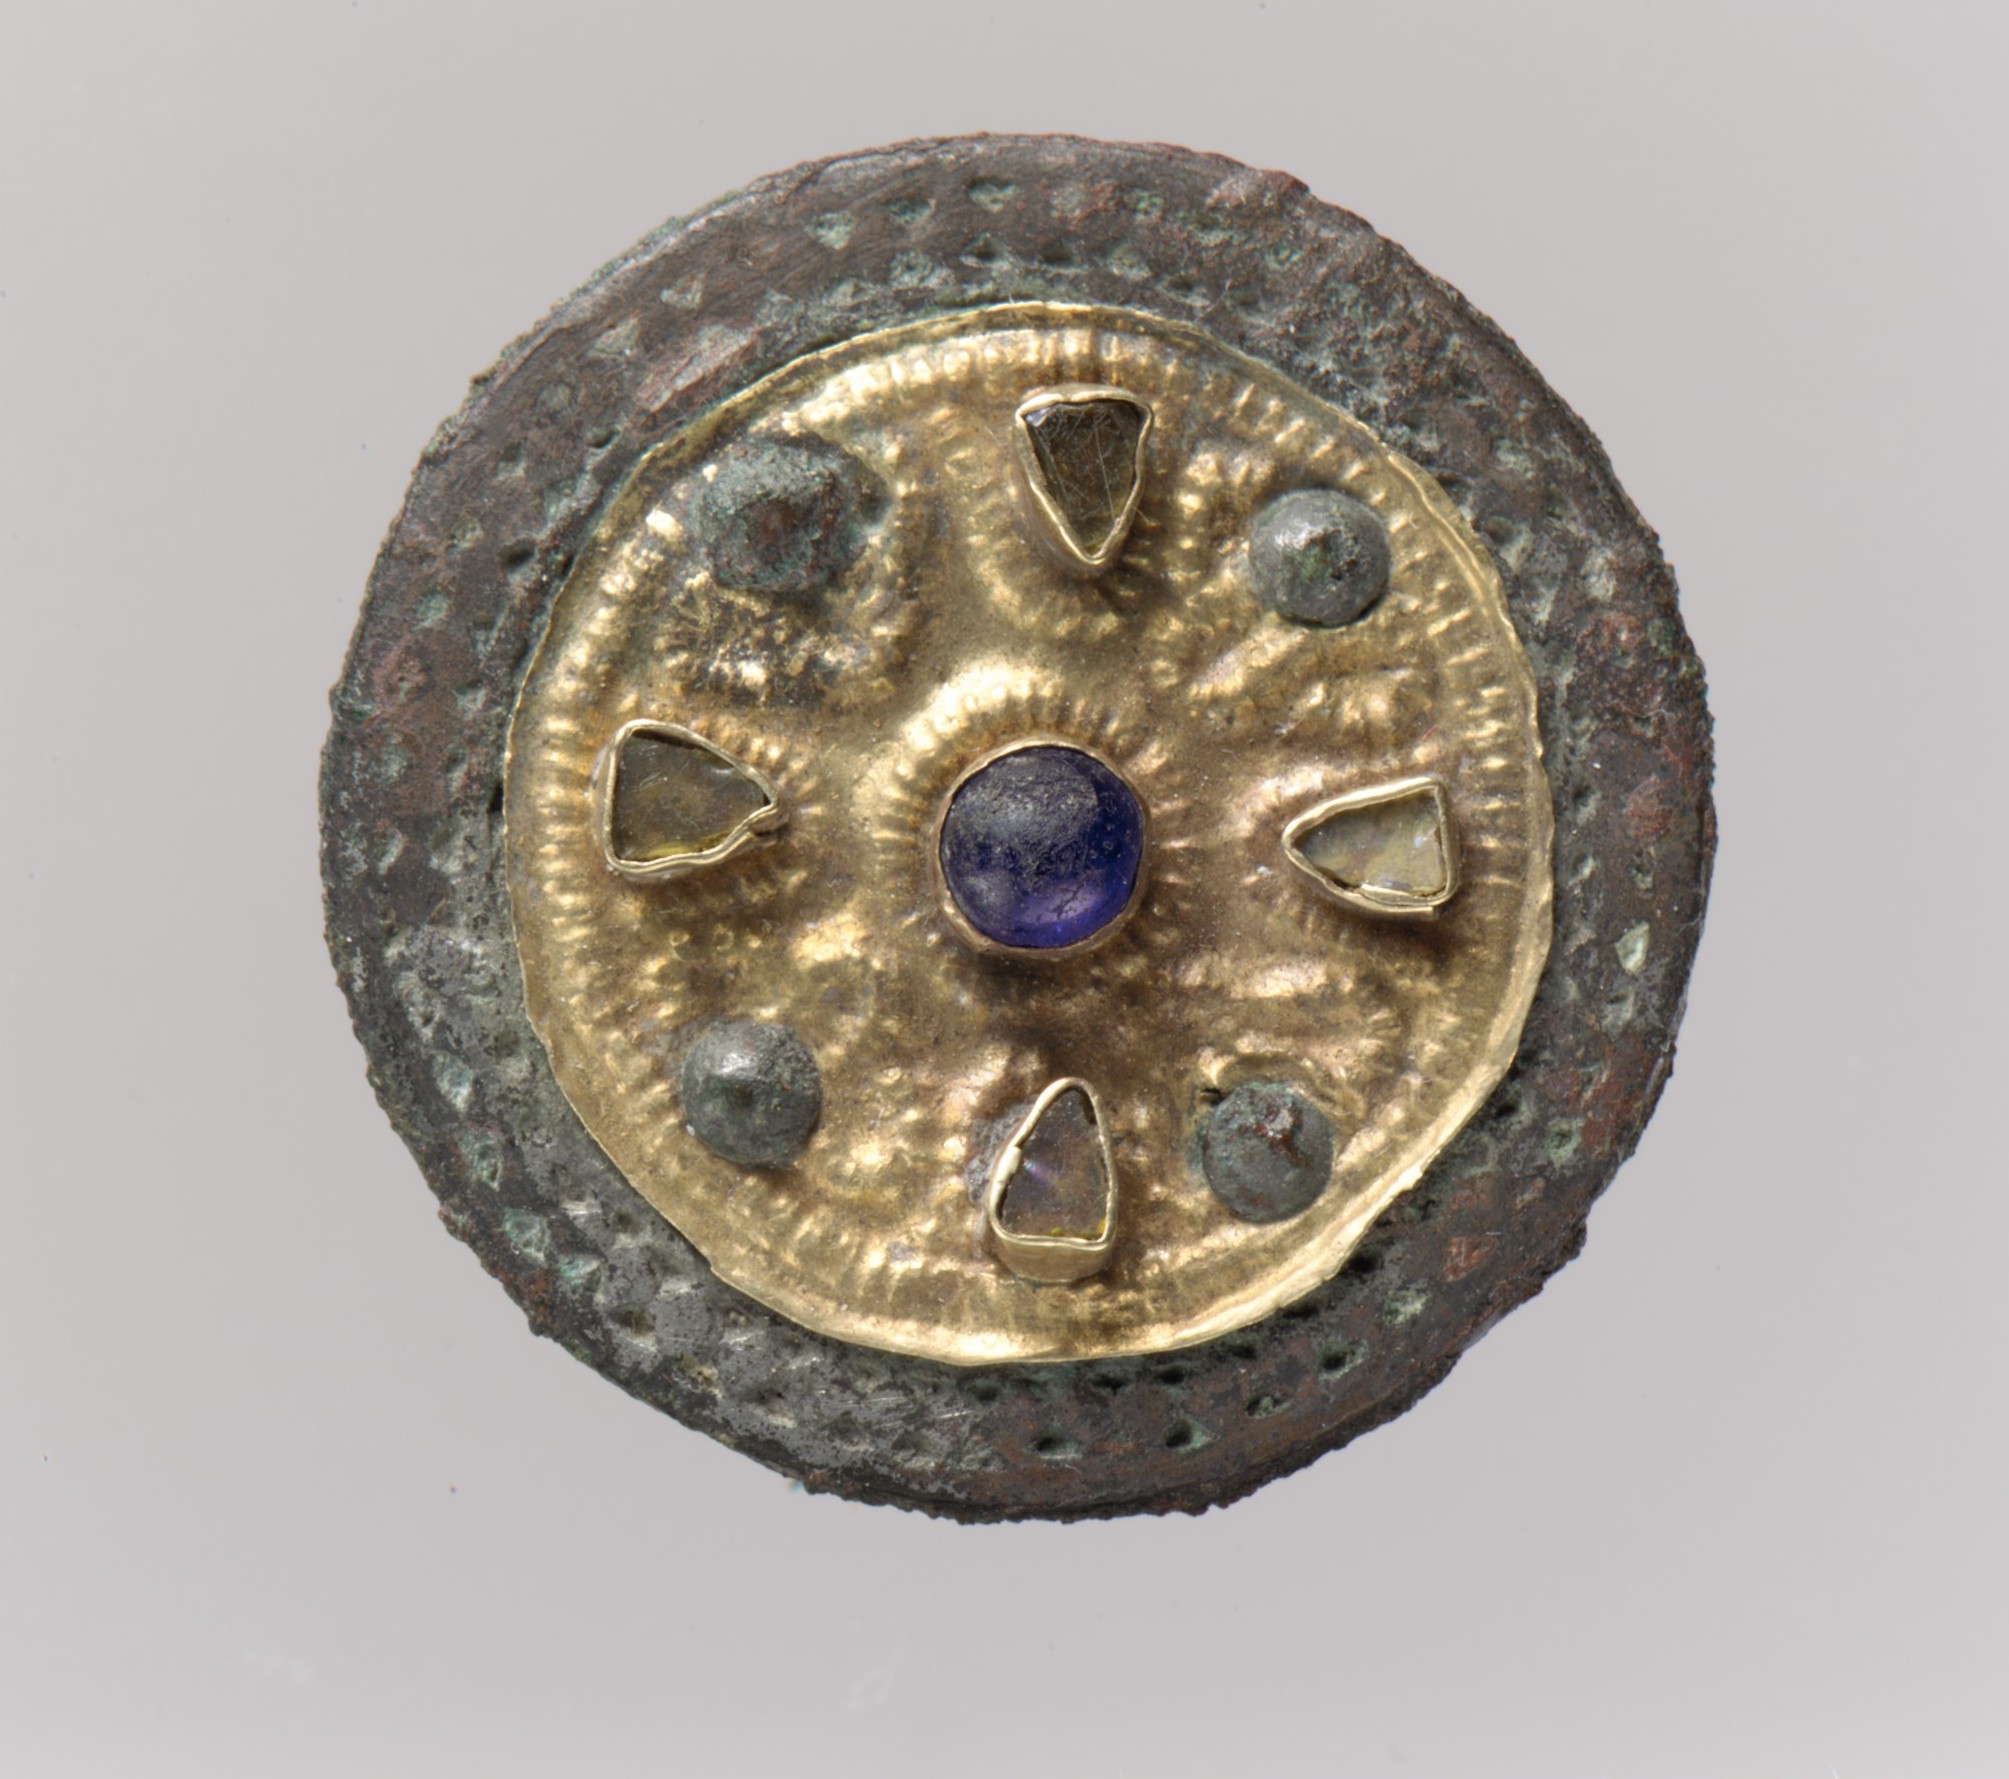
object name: brooch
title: Disk Brooch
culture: frankish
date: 550-650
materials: copper alloy, glass, gold, paste